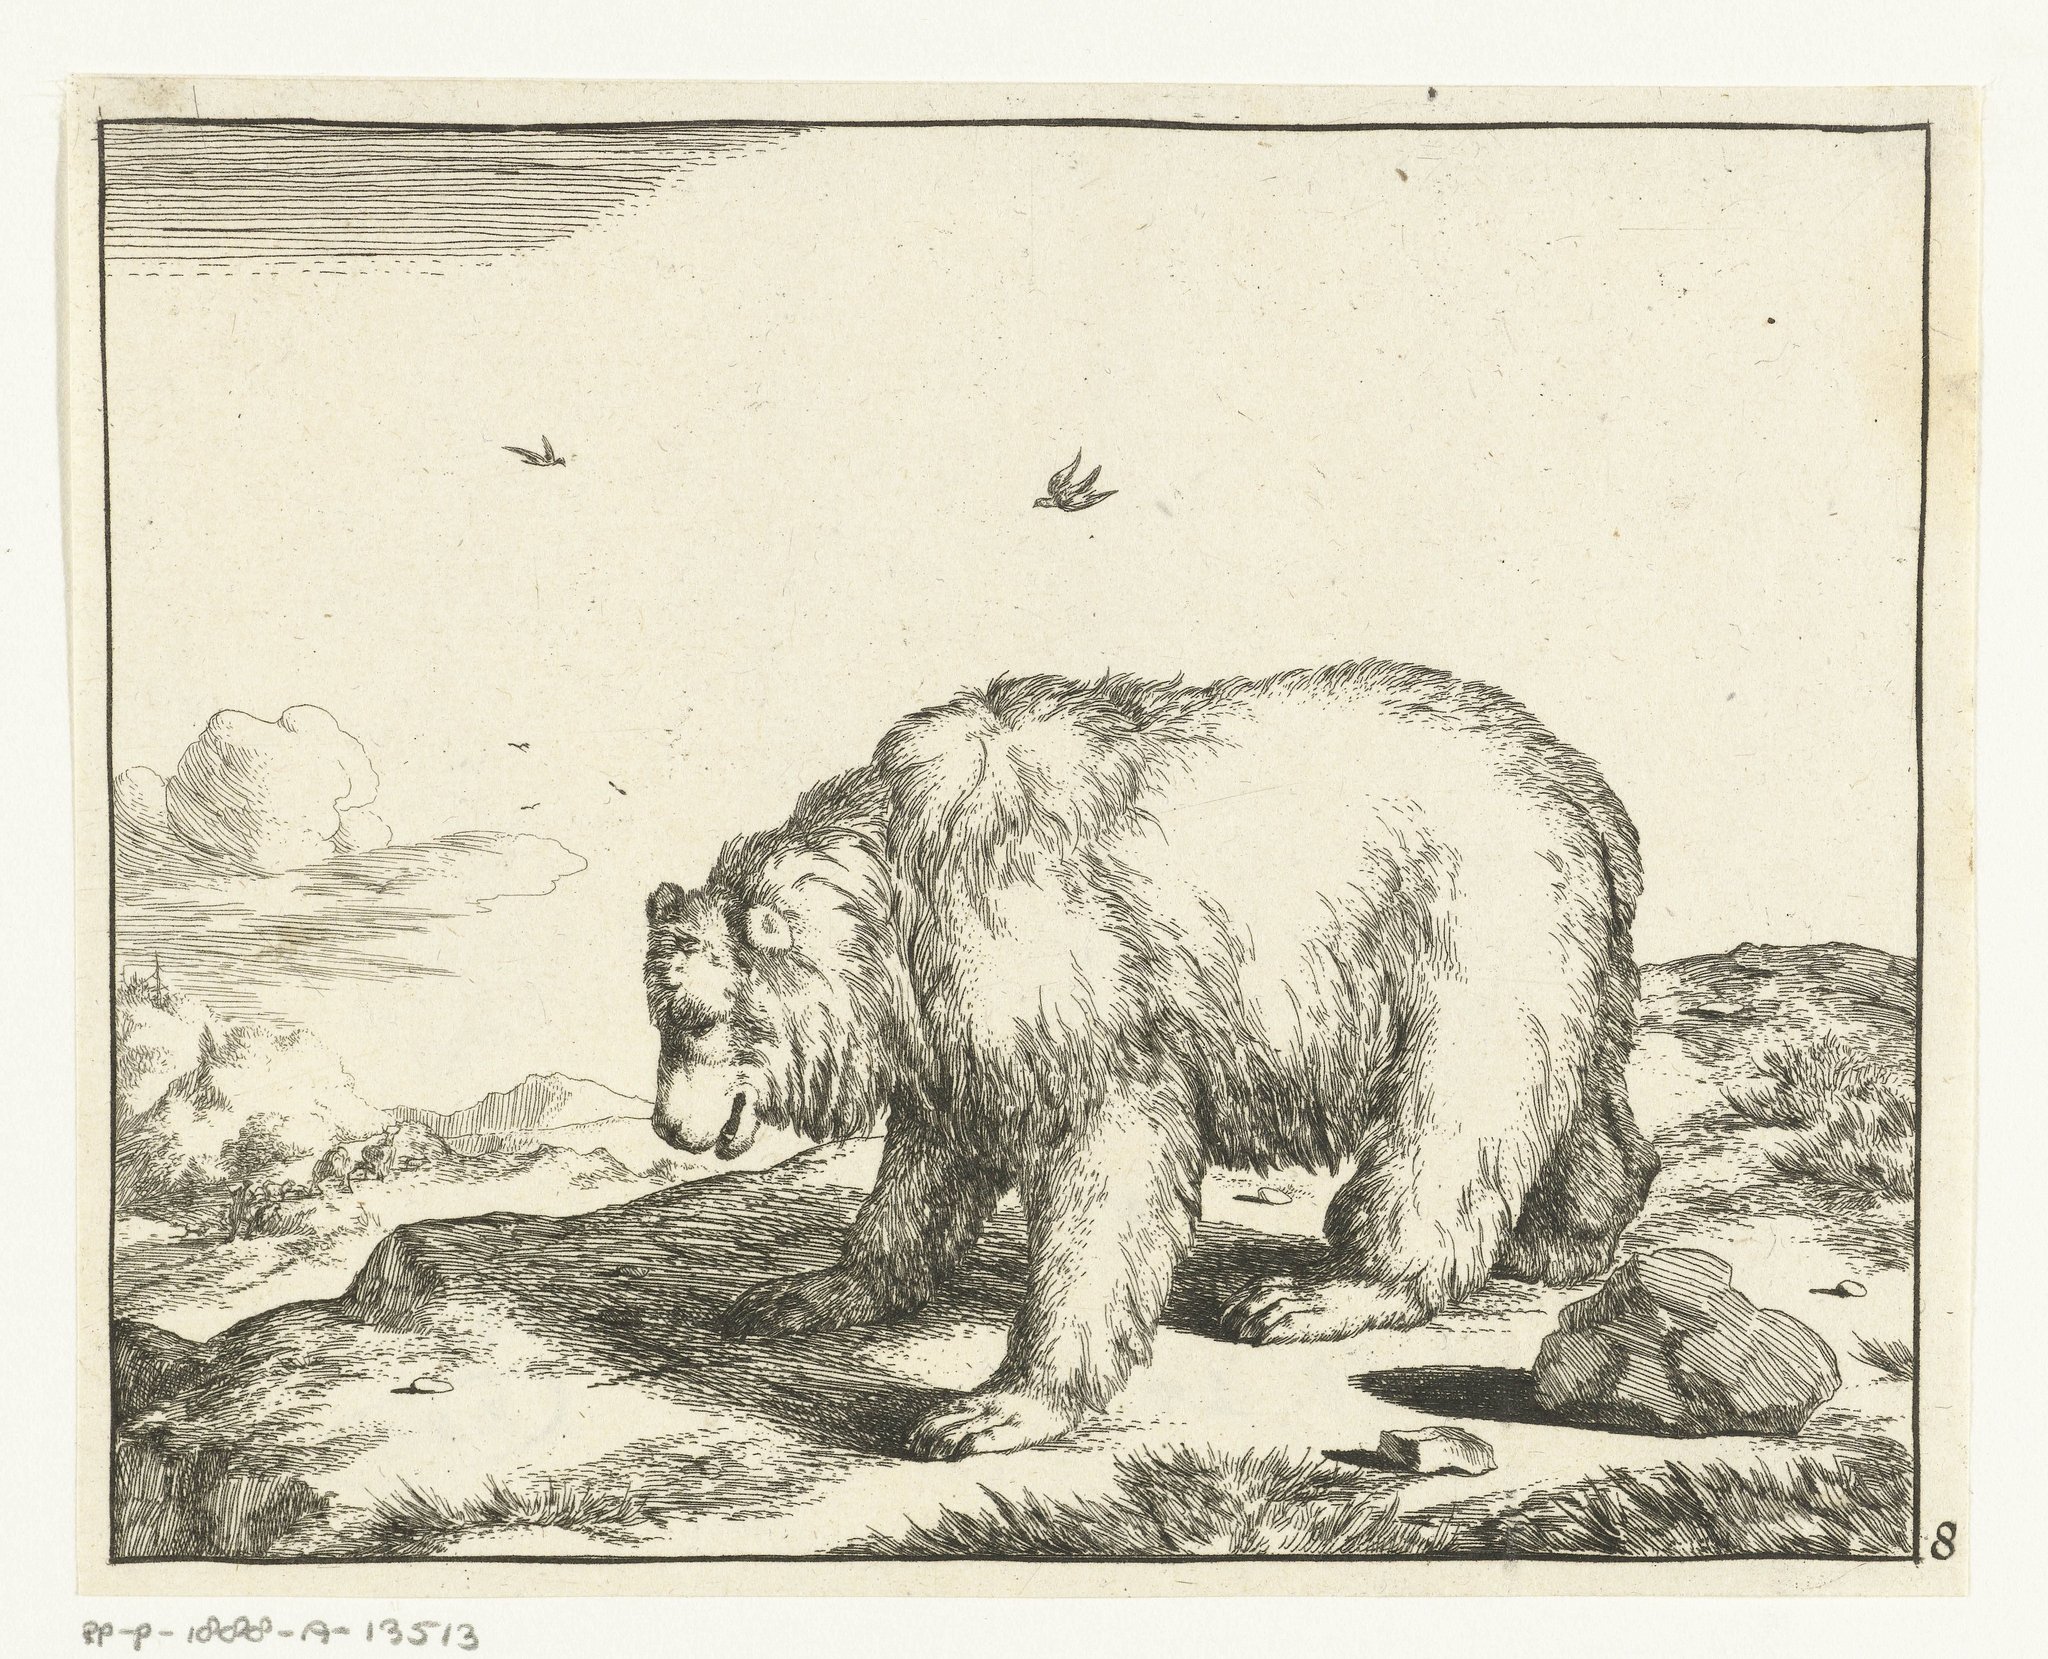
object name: print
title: Staande beer, en profil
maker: marcus de bye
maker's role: print maker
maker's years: 1639-1688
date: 1664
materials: paper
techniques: etching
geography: the hague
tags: beasts of prey, predatory animals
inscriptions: collector's mark: Lugt 2228